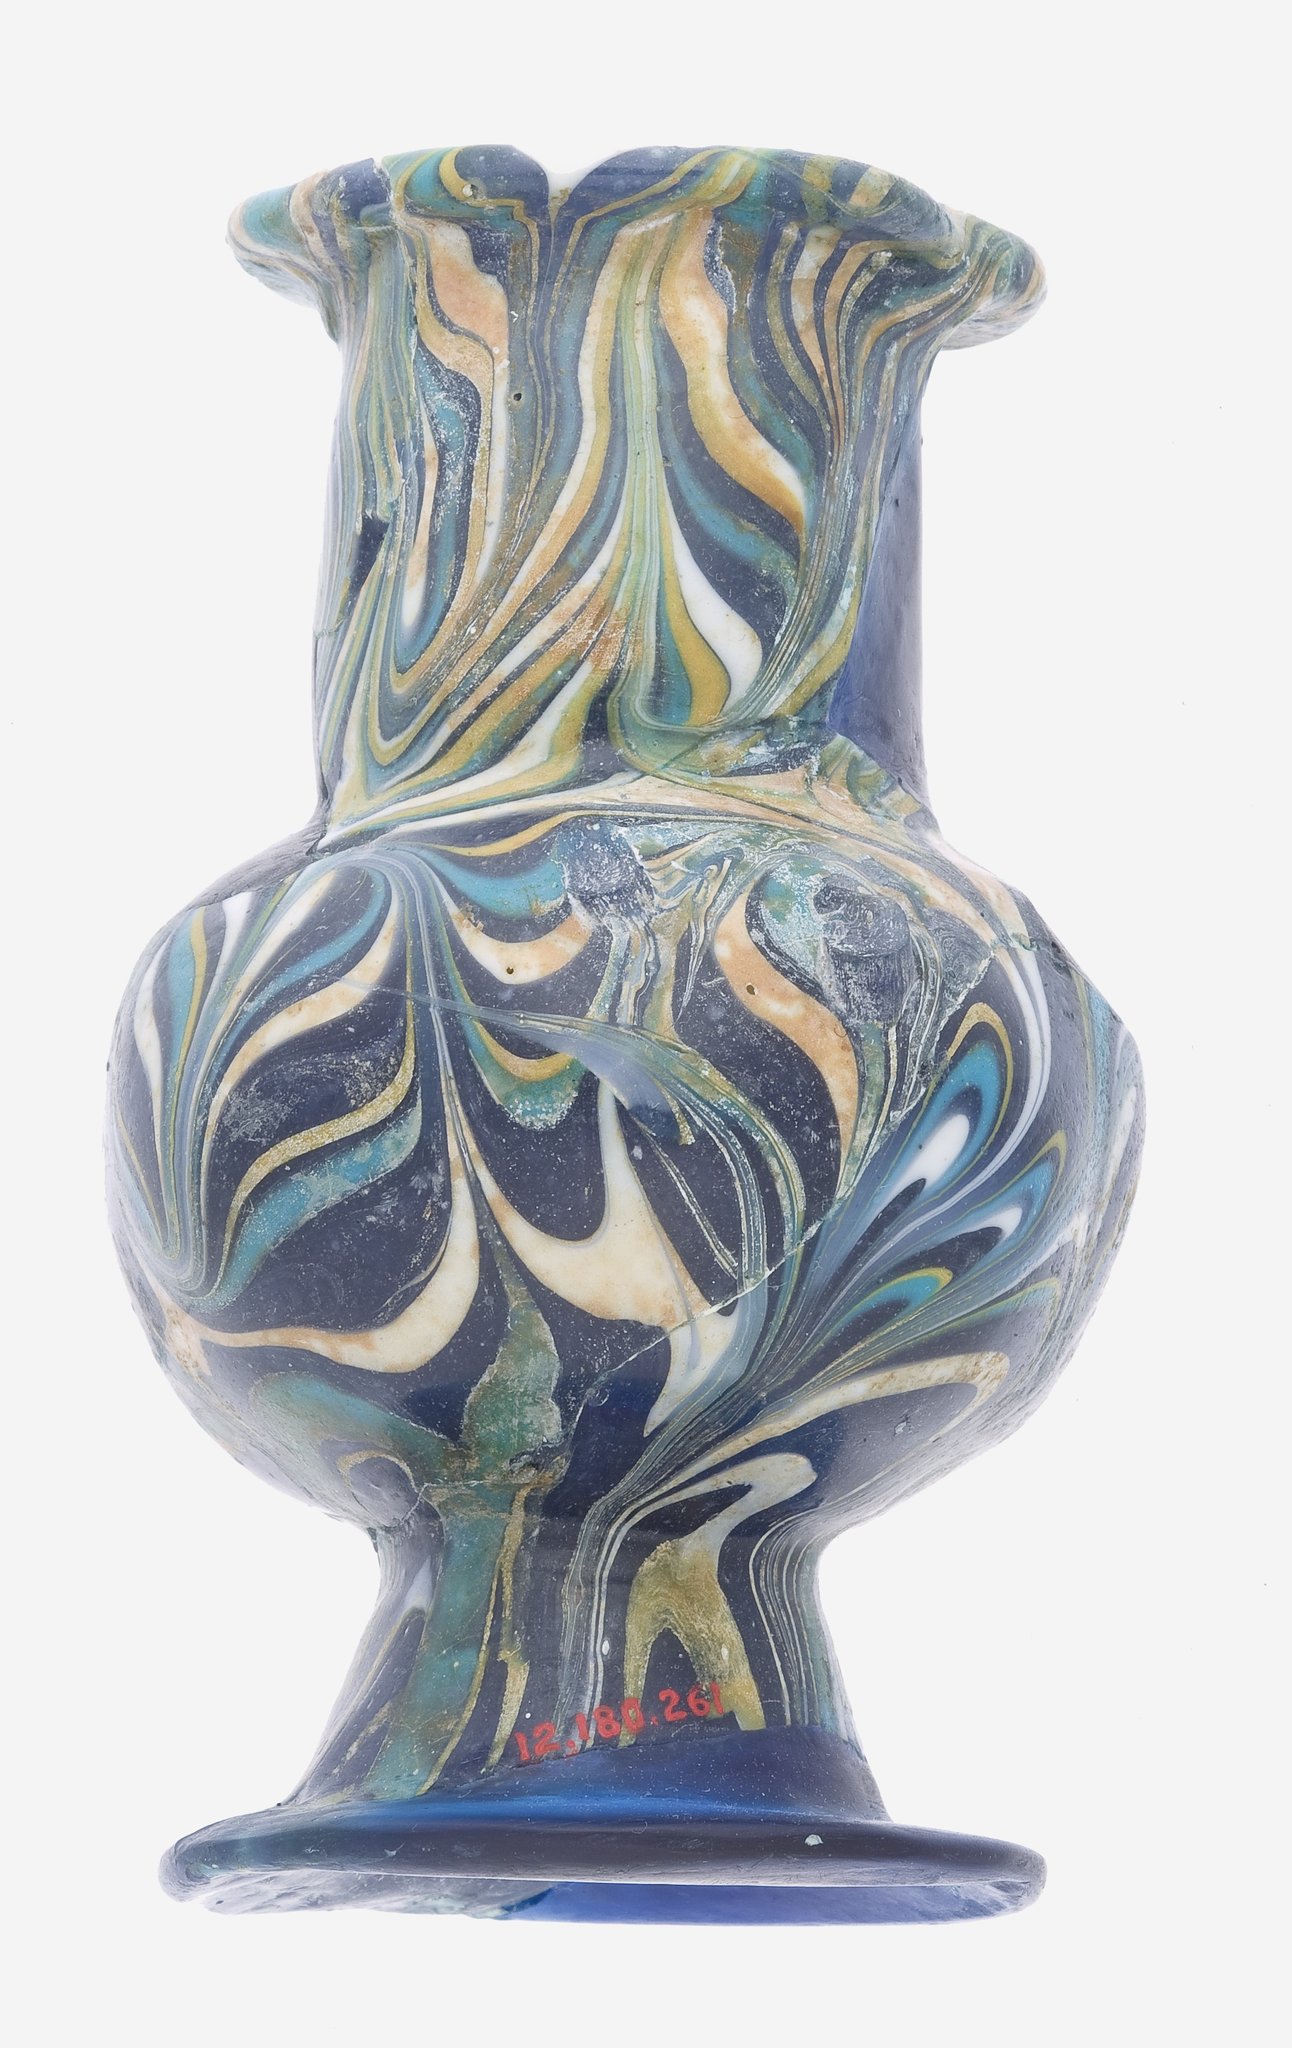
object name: vase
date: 1390-1352 BCE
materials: glass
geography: egypt